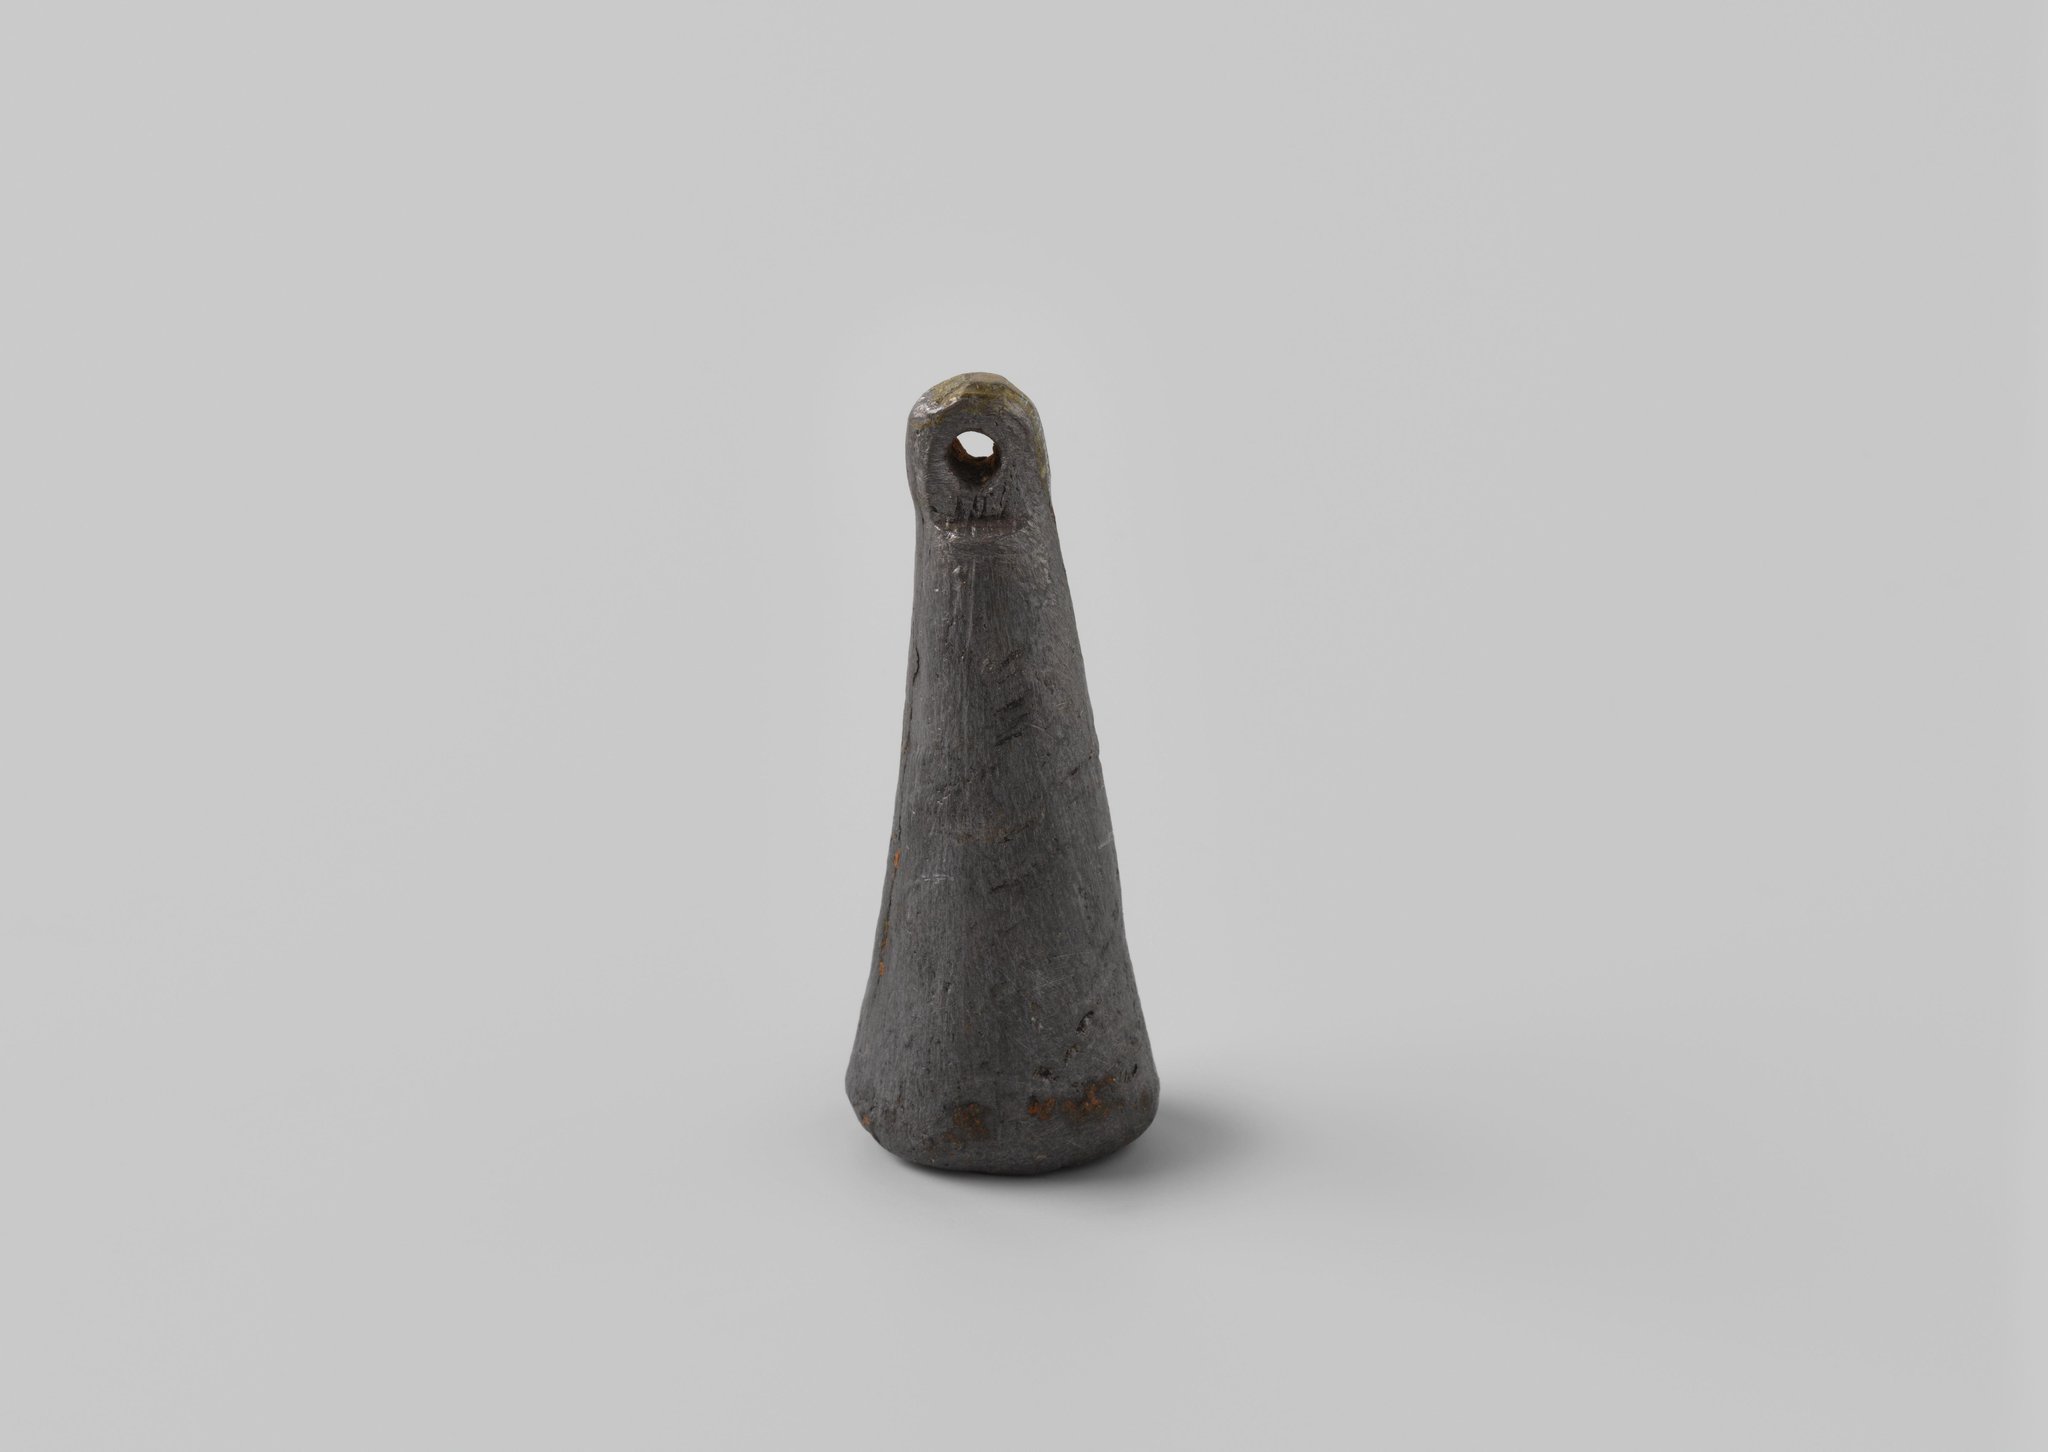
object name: sounding lead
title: Sounding lead from the wreck of the Dutch East Indiaman Hollandia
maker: Anonymous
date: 1700-1743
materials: lead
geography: netherlands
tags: verenigde oostindische compagnie, hollandia (schip), annet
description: Oval concave base, tapering upwards, flattened semicircular pierced upper end.